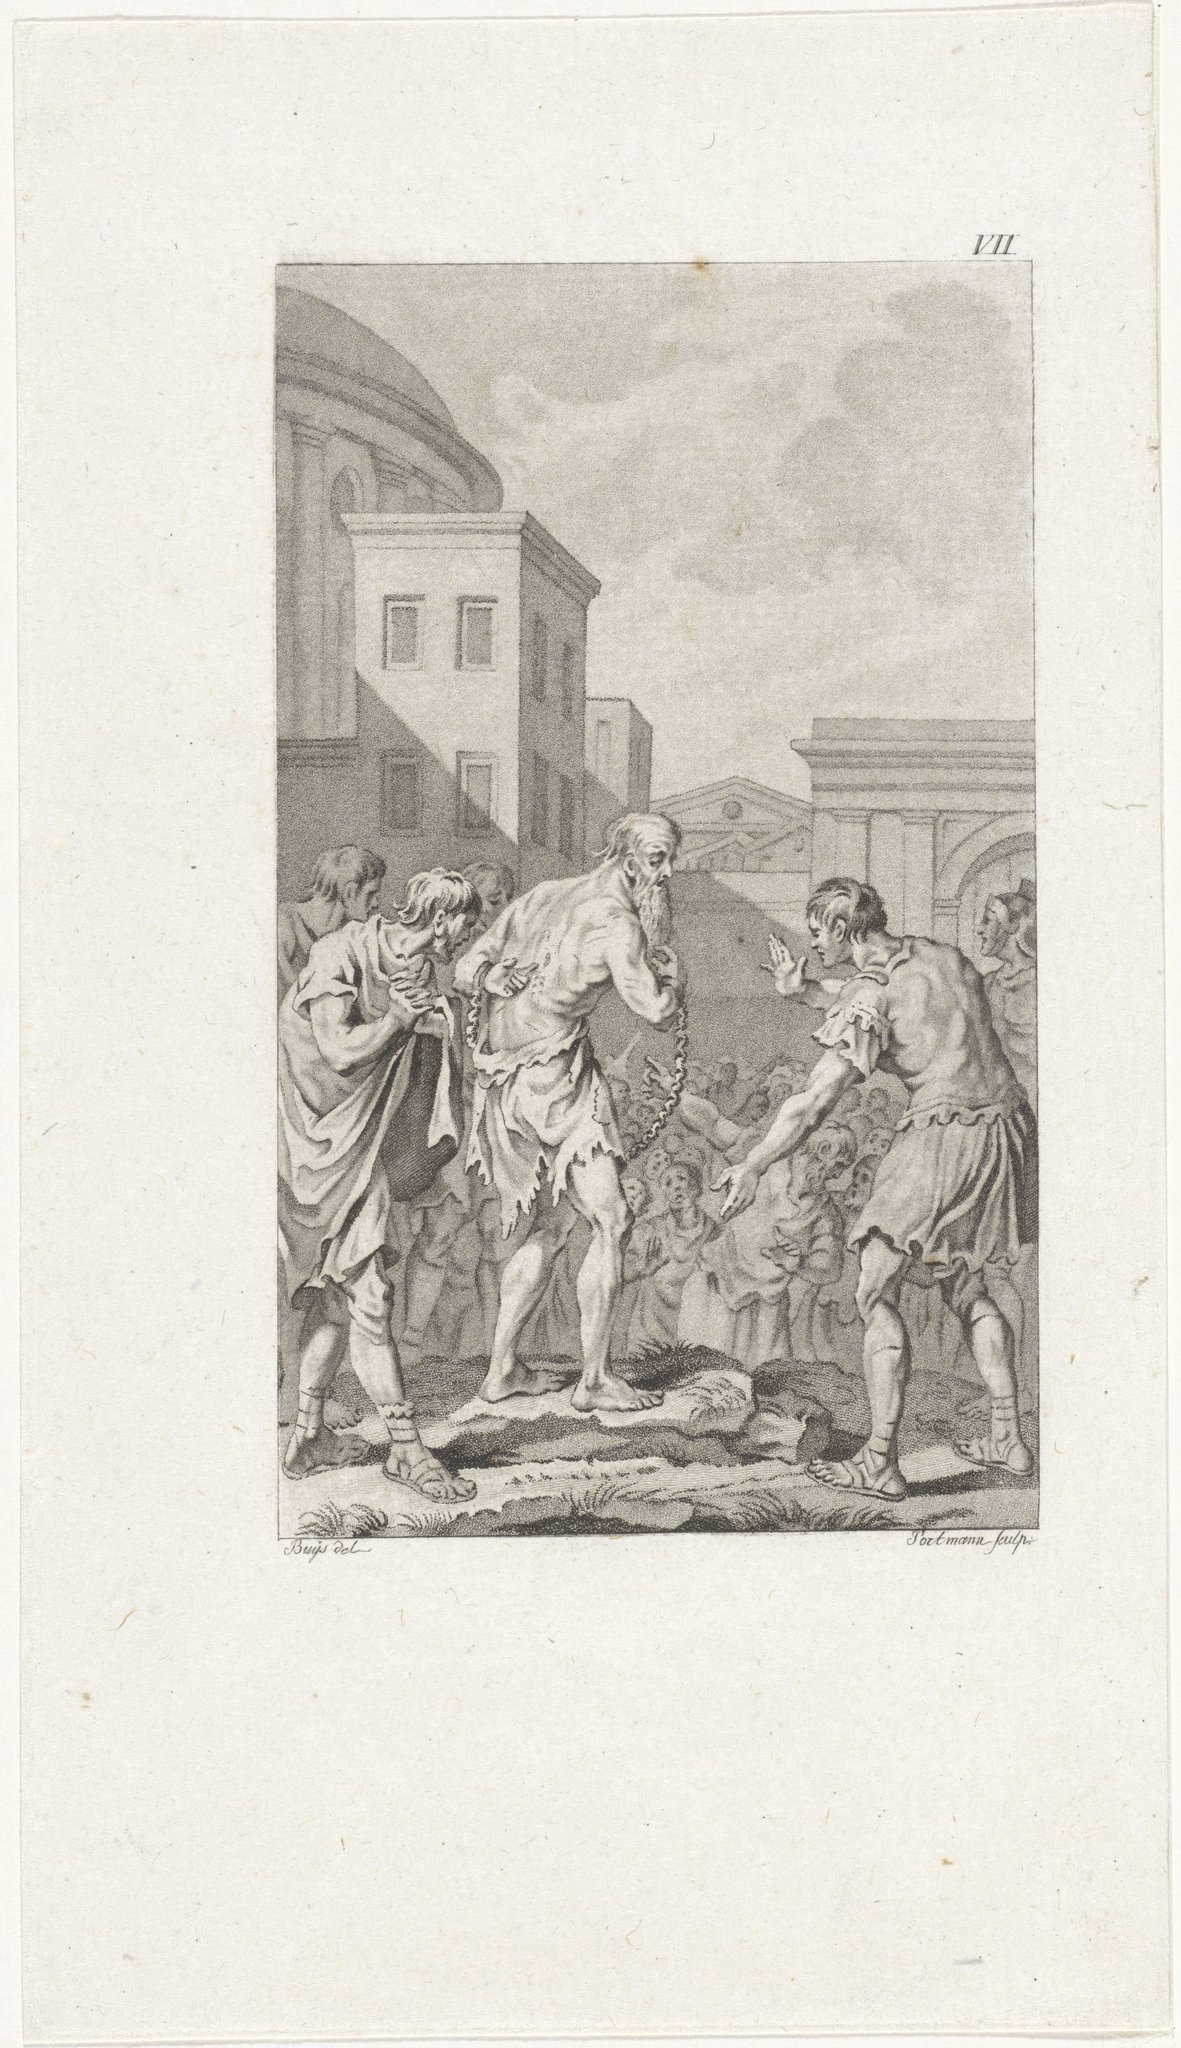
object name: print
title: Oproer door ontsnapte bejaarde schuldenaar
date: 1793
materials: paper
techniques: stippled etching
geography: utrecht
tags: debit and credit (+ variant), male persons from classical history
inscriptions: collector's mark: Lugt 2228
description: Een bejaarde, geketende schuldenaar is zijn schuldeiser ontvlucht. Op het marktplein toont hij zich aan het toegestroomde volk dat in woede uitbarst.